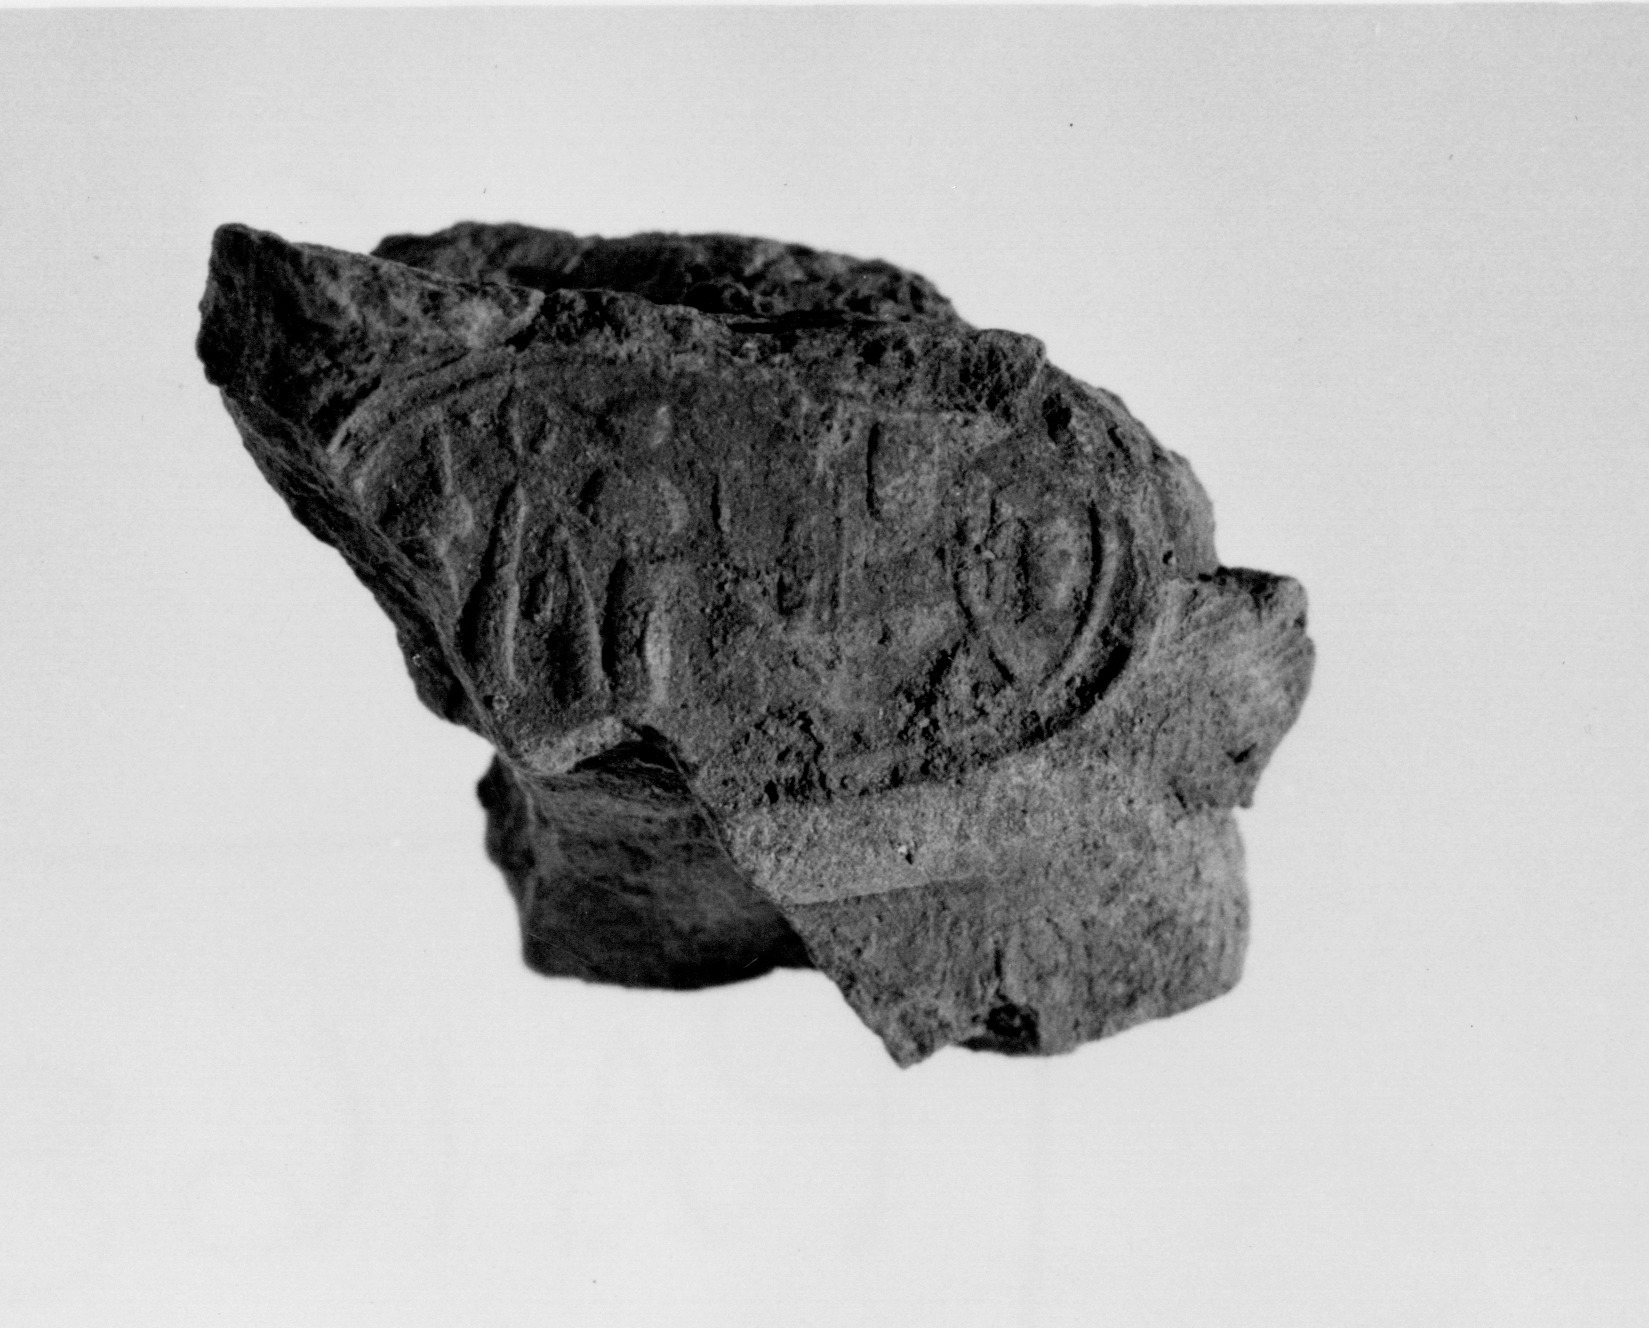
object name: sealing, nebmaatre, amenhotep iii, ptah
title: Document Sealing With the Throne Name of Amenhotep III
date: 1390-1352 BCE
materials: mud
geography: egypt